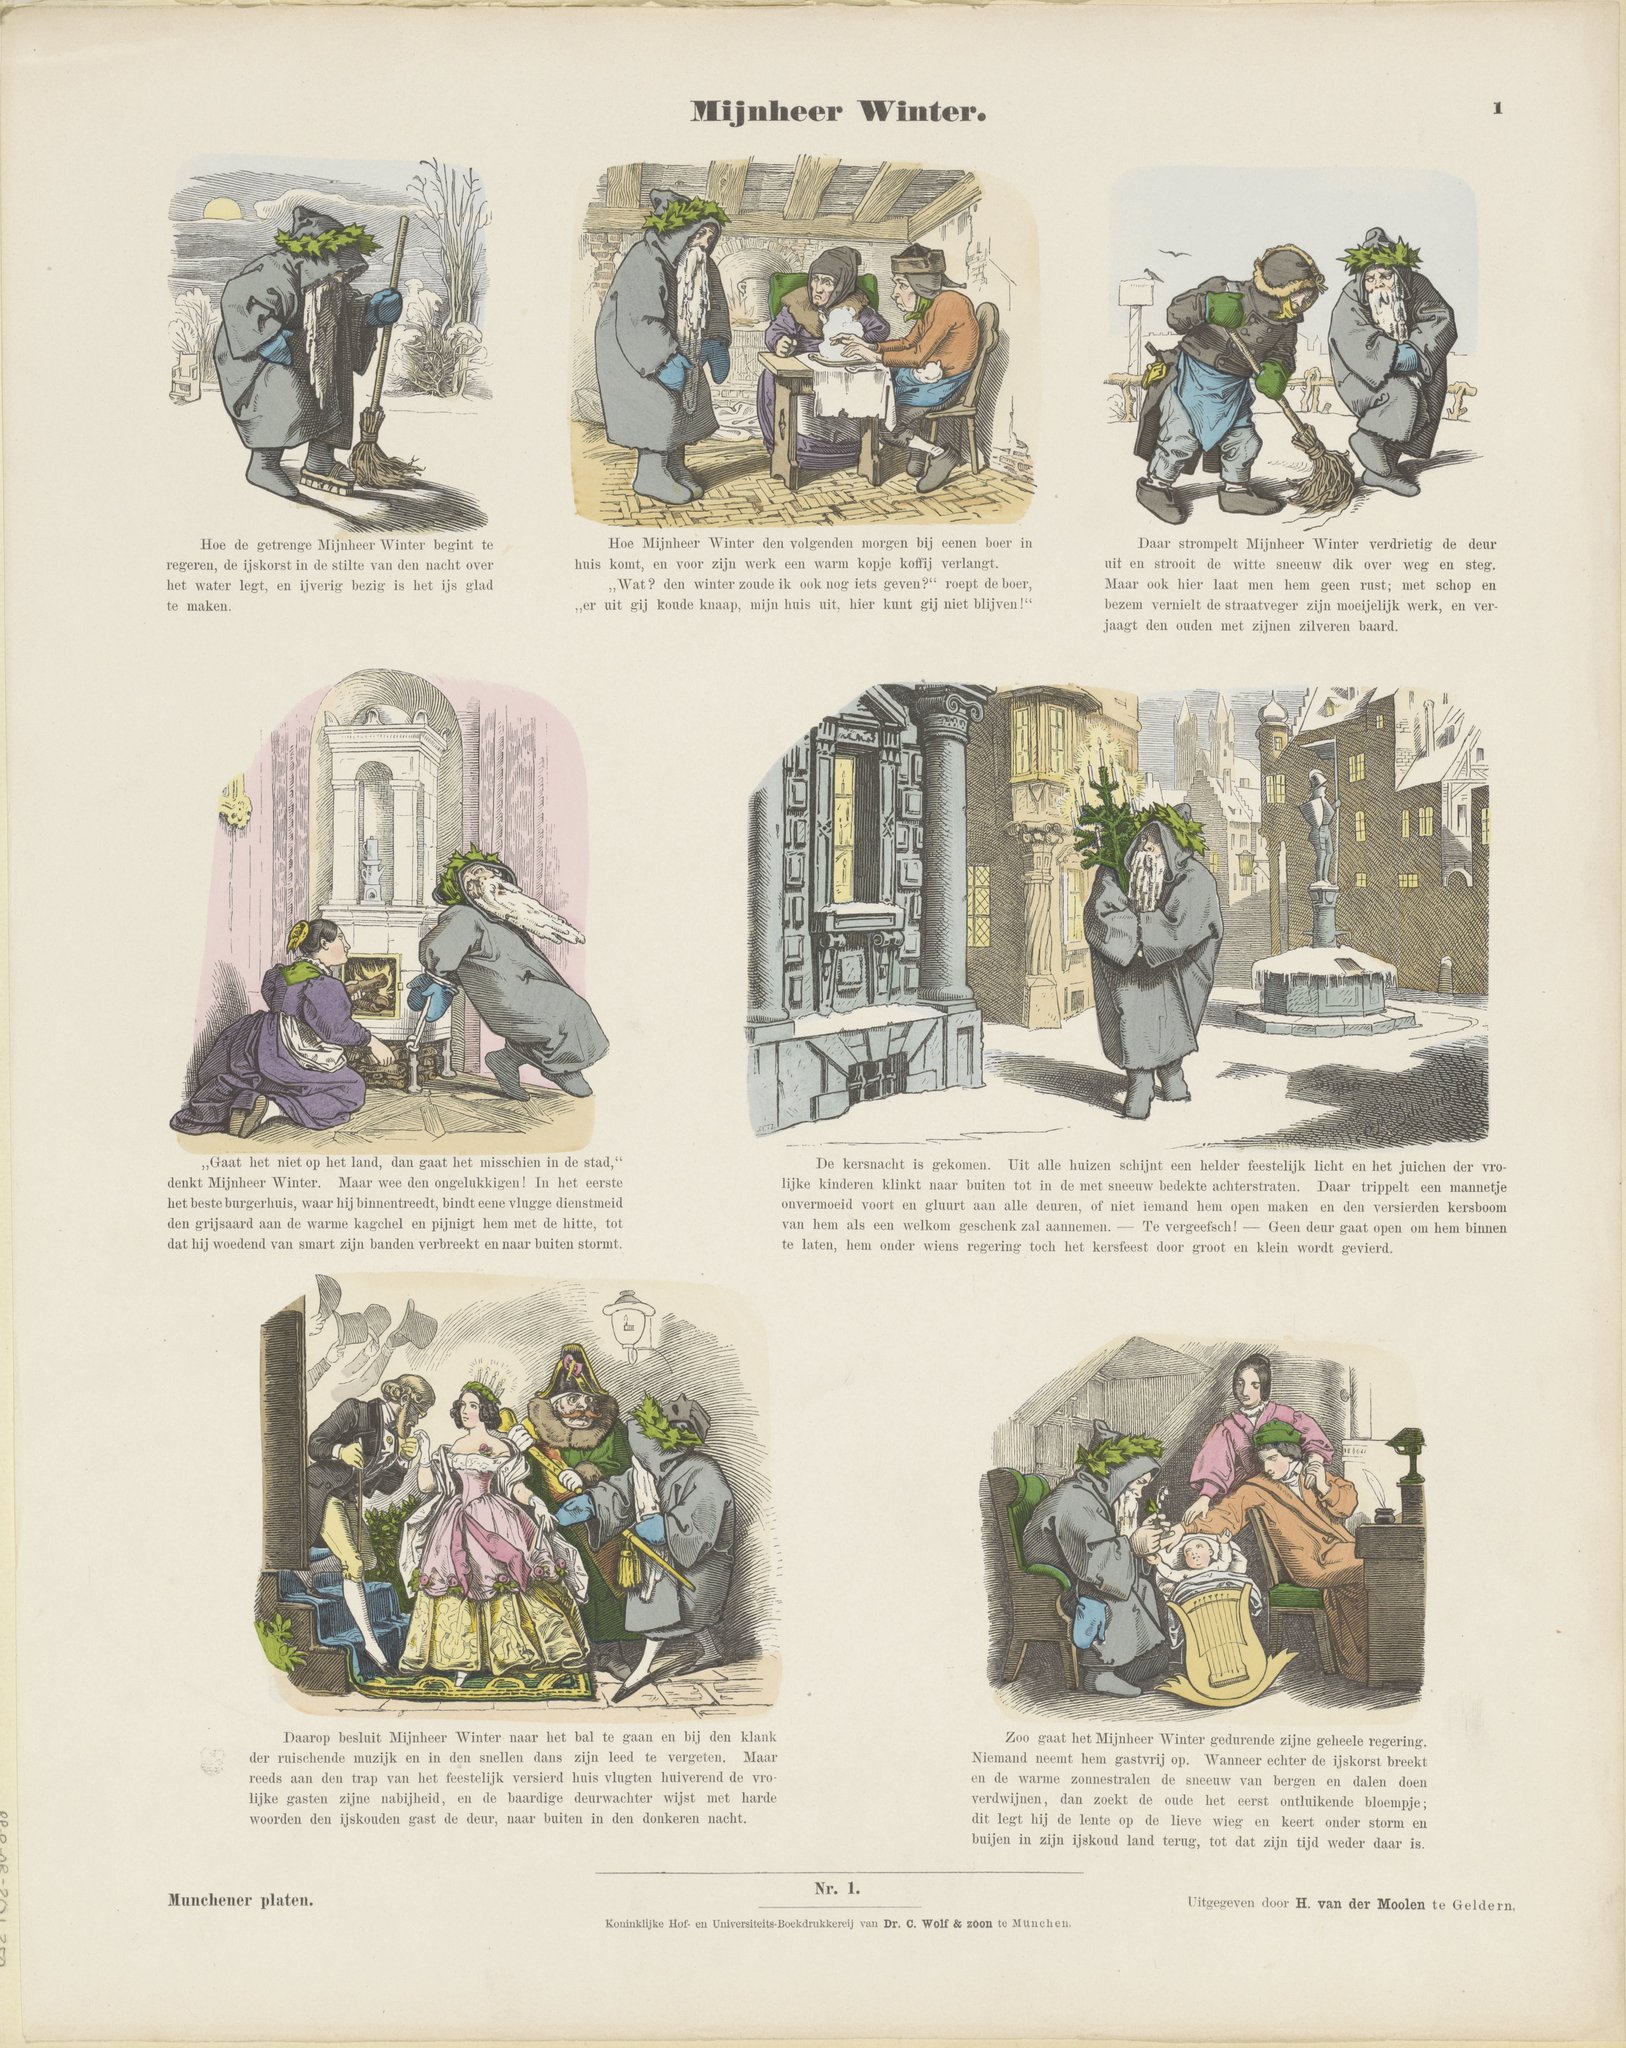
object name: print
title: Mijnheer Winter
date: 1843-1920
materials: paper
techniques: colour, letterpress printing, engraving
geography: munich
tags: winter, 'hyems'; 'inverno' (ripa) (+ ways of representing seasons and months)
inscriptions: collector's mark: Lugt 2760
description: Nederlandse editie van een prent uit de reeks "Munchener platen" uitgegeven door K. Braun & Fr. Schneider te München met het adres van wederverkoper Hermann van der Moolen.